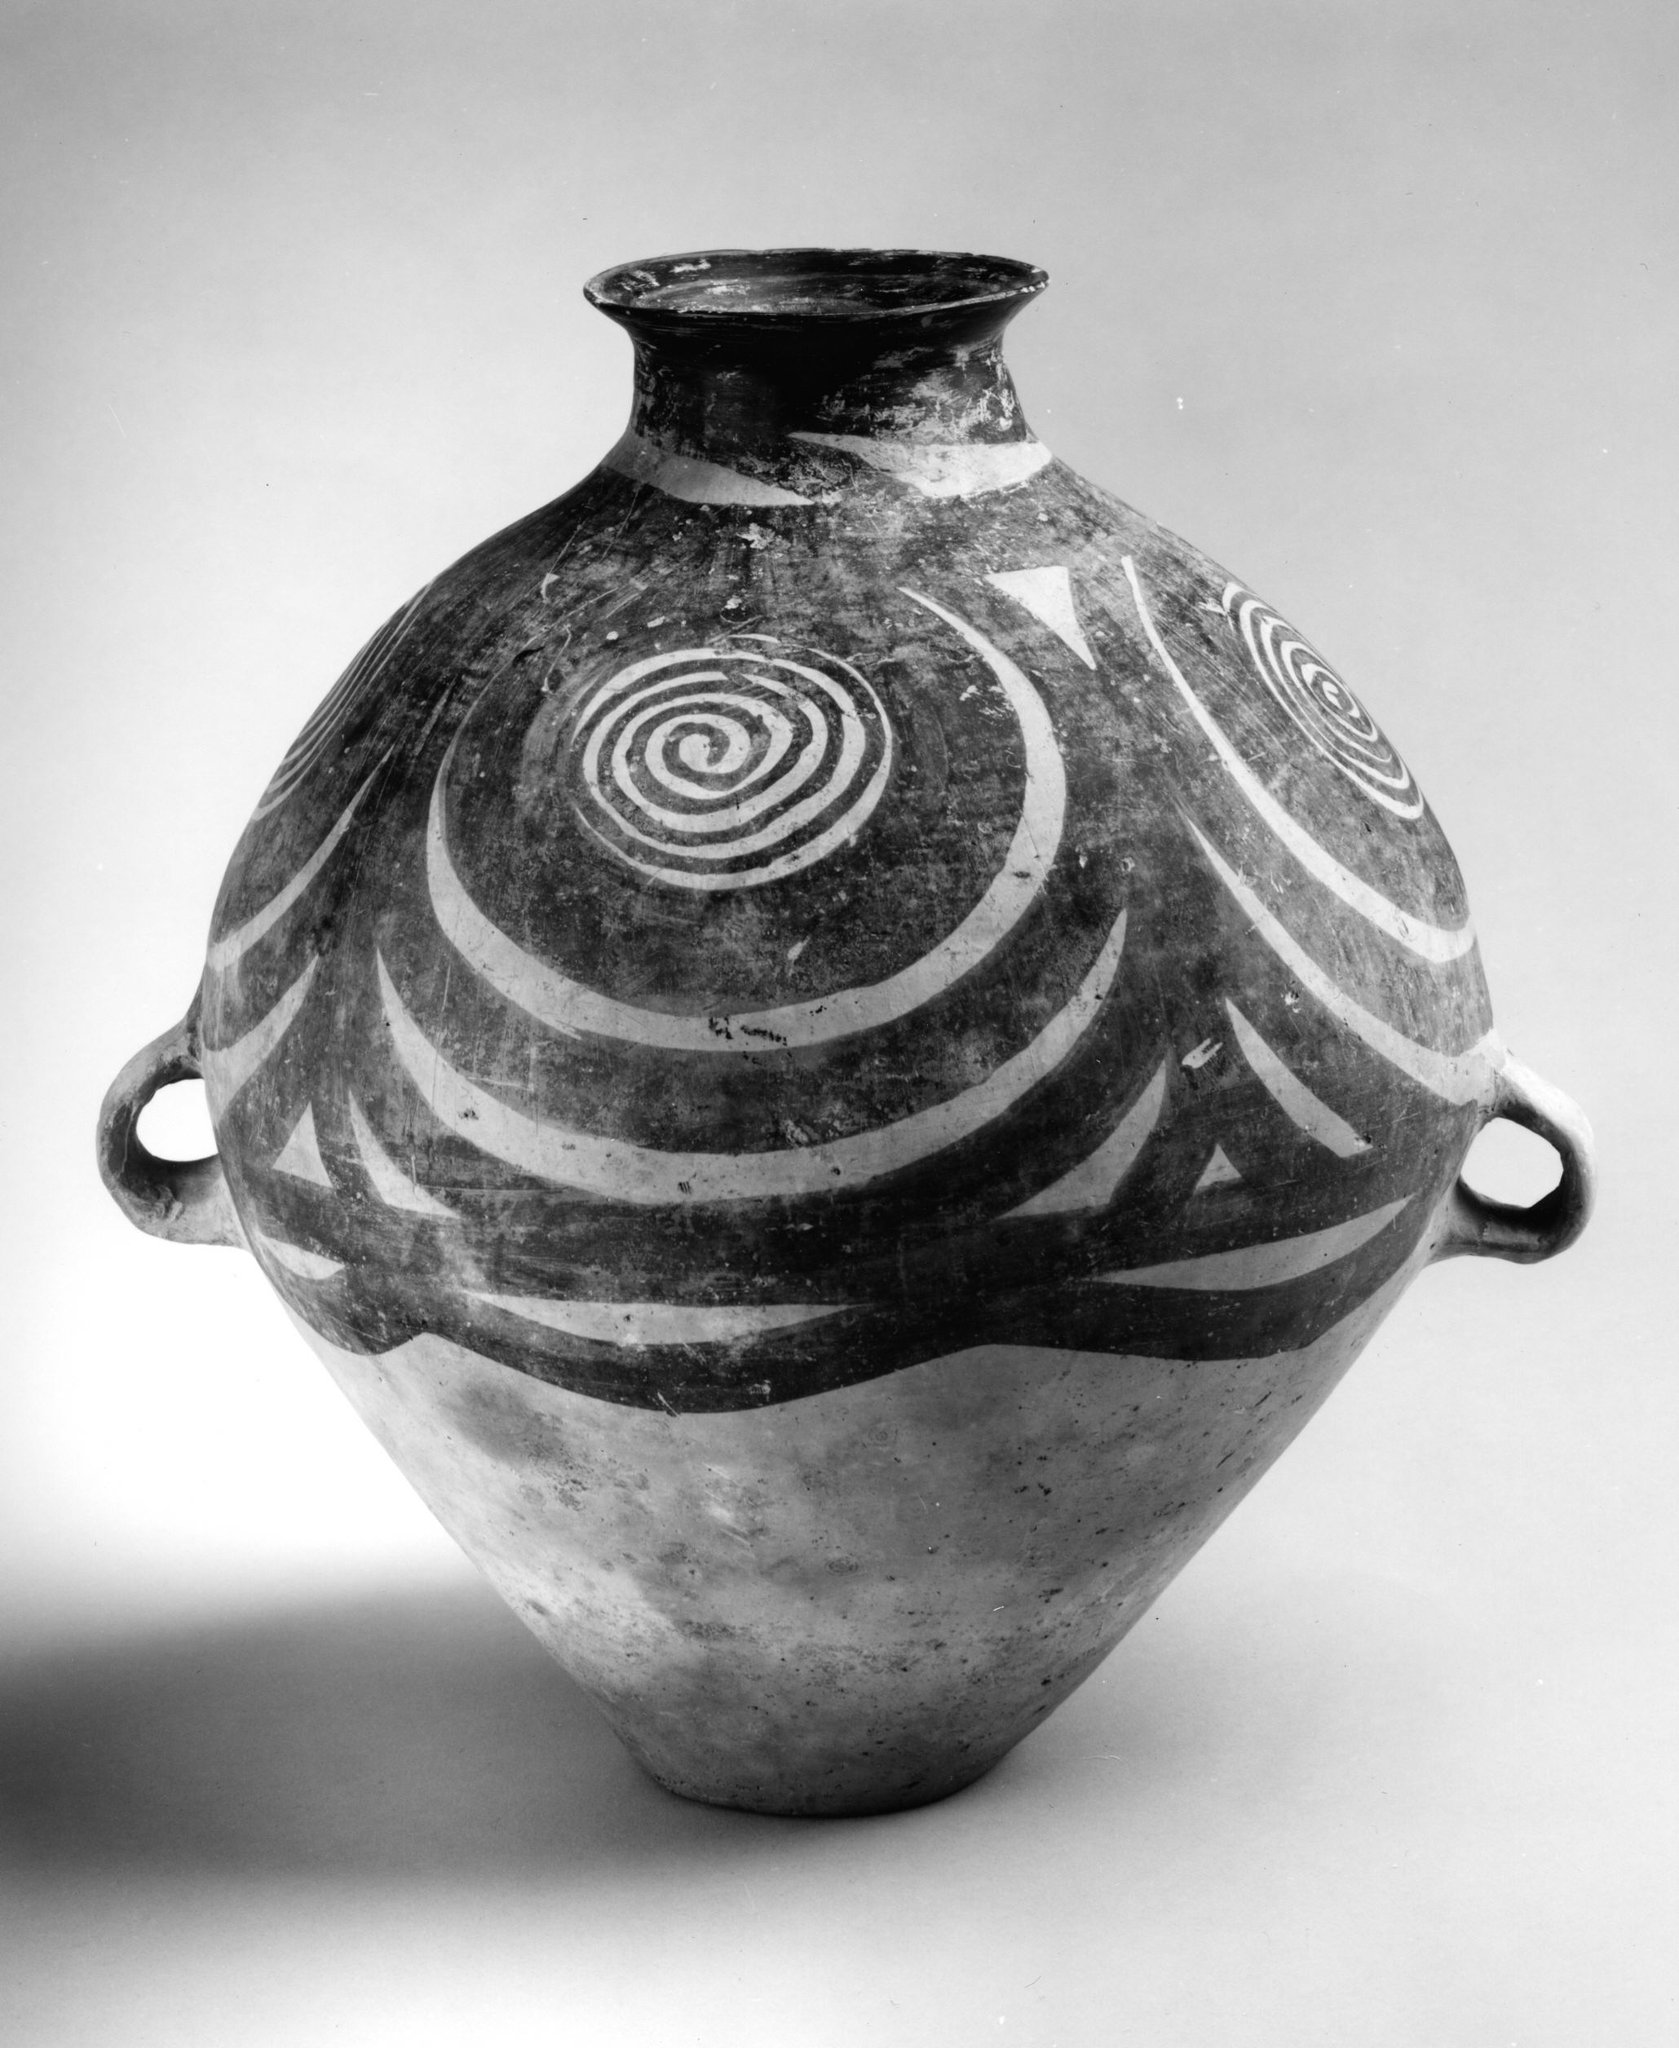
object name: jar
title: Jar with Spiral Decoration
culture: chinese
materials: earthenware, pigment